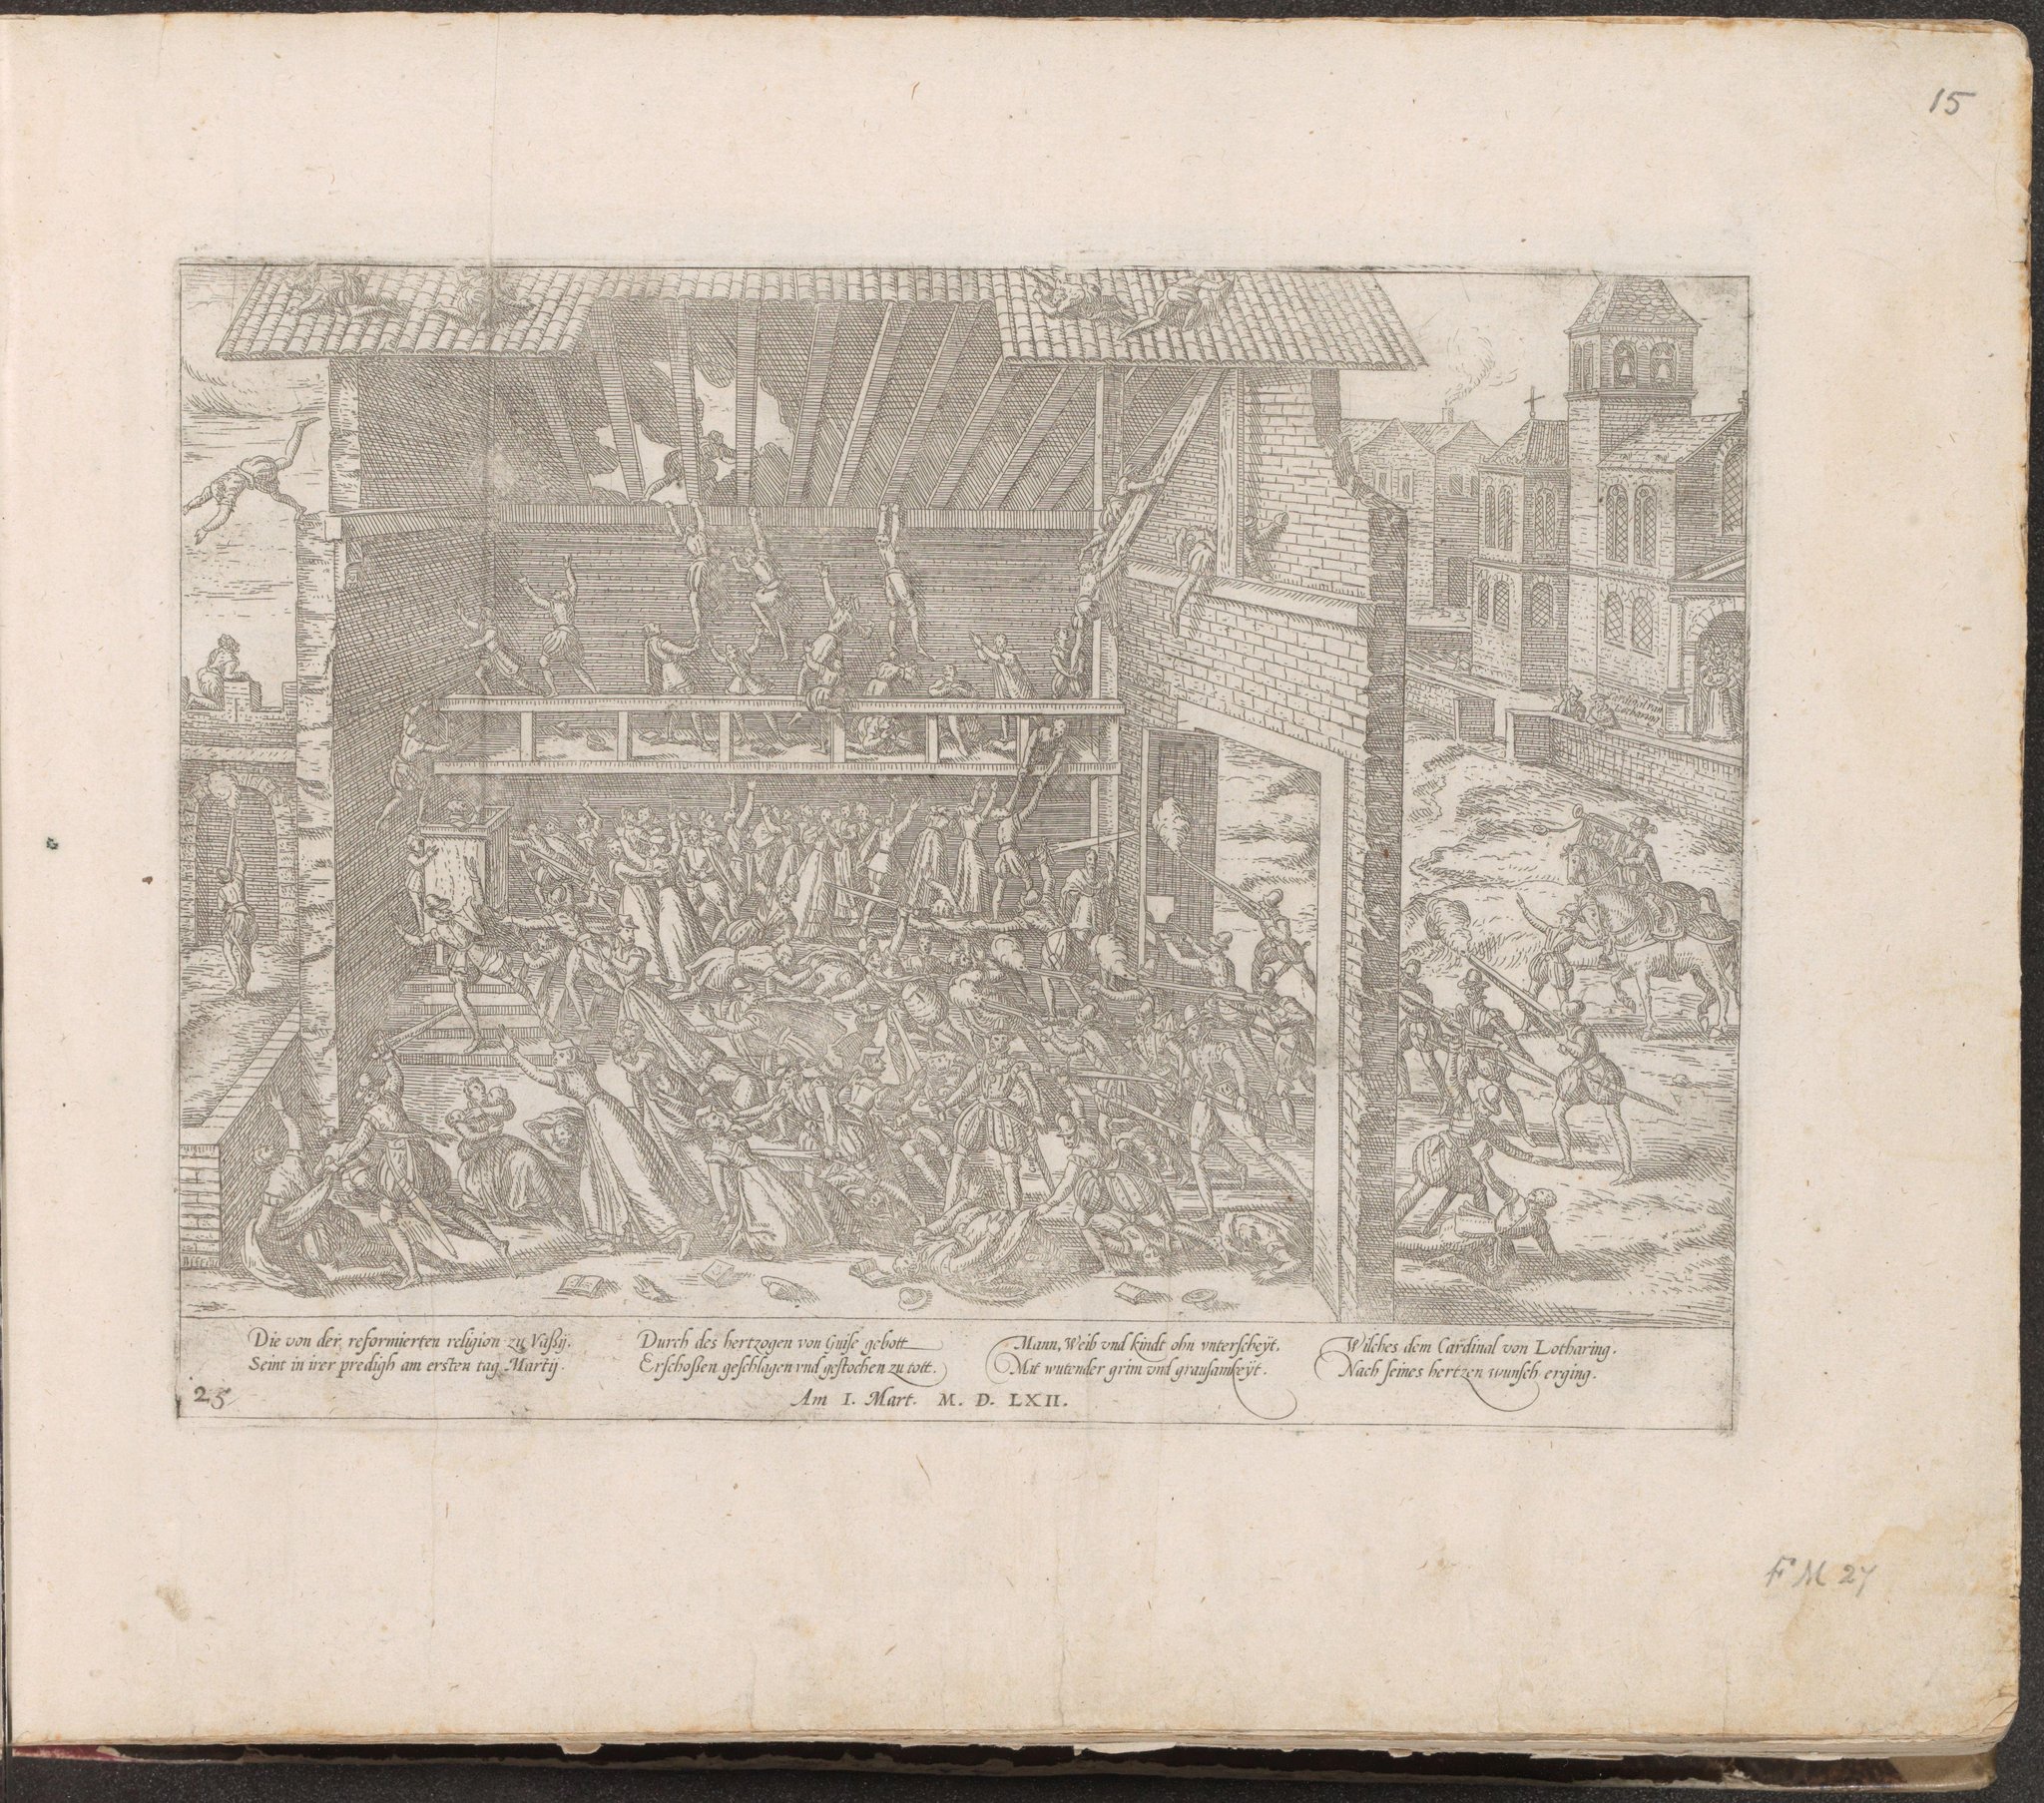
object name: album leaf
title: Moord op de protestanten te Wassy, 1562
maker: frans hogenberg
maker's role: print maker, publisher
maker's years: 1538-1590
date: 1567-1571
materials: paper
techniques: etching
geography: cologne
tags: massacre ~ war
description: Moord op de protestanten tijdens een bijeenkomst te Wassy (Wassy-sur-Blaise), 1 maart 1562, door soldaten van de hertog de Guise. Met onderschrift van 8 regels in het Duits. Linksonder genummerd: 25. De prent maakt deel uit van een album.